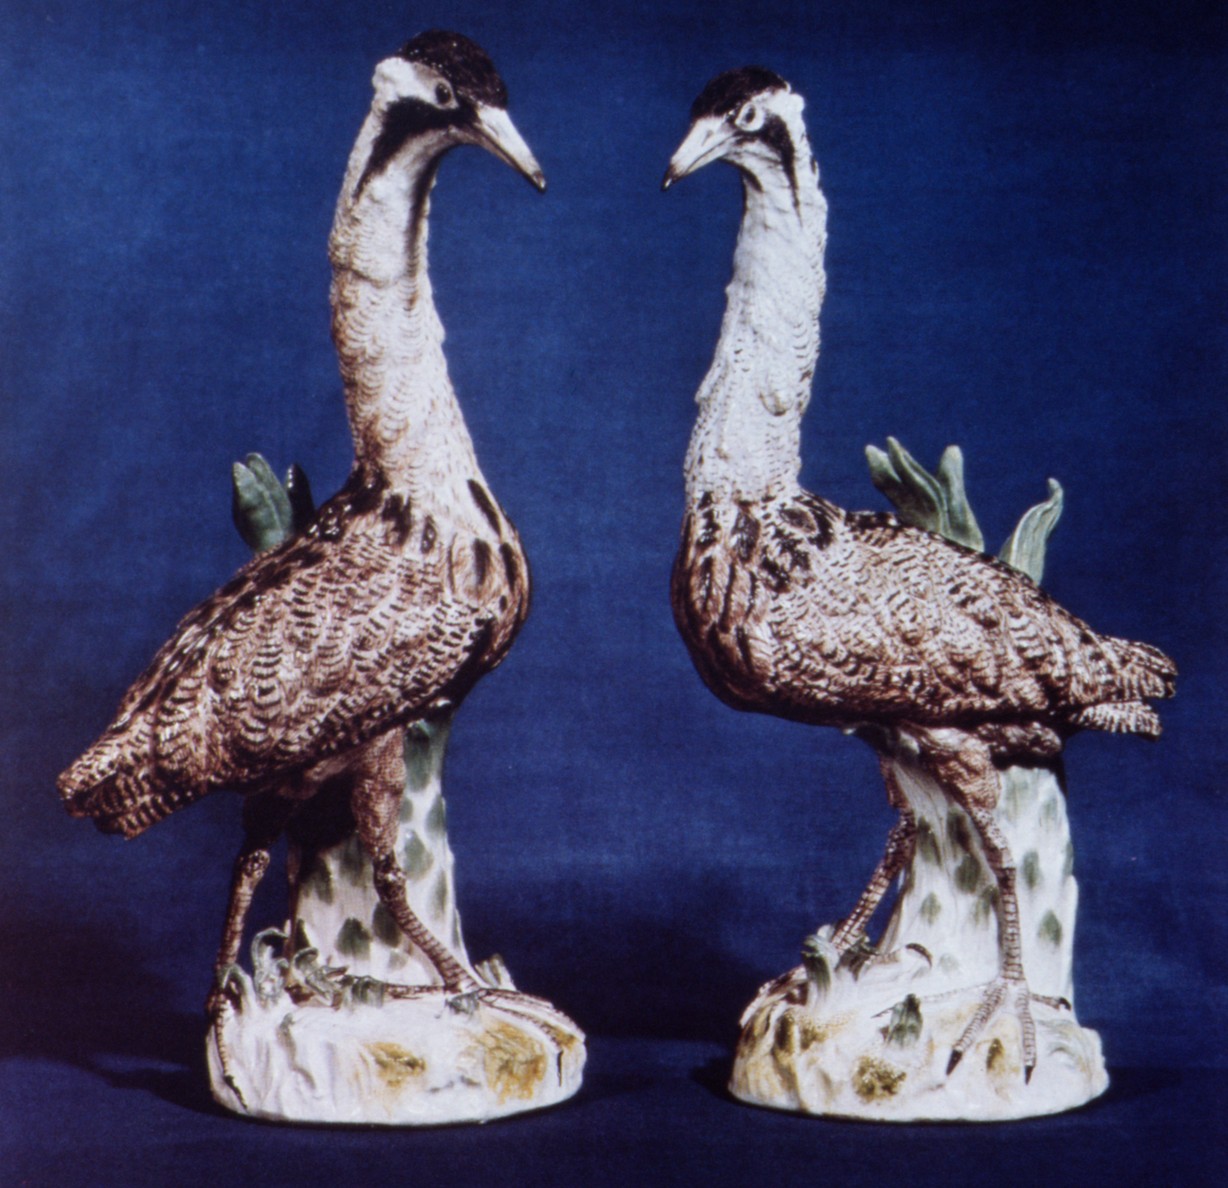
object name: figure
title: Bittern (one of a pair)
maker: meissen manufactory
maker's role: manufactory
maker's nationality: german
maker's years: 1710-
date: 1750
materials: hard paste porcelain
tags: birds